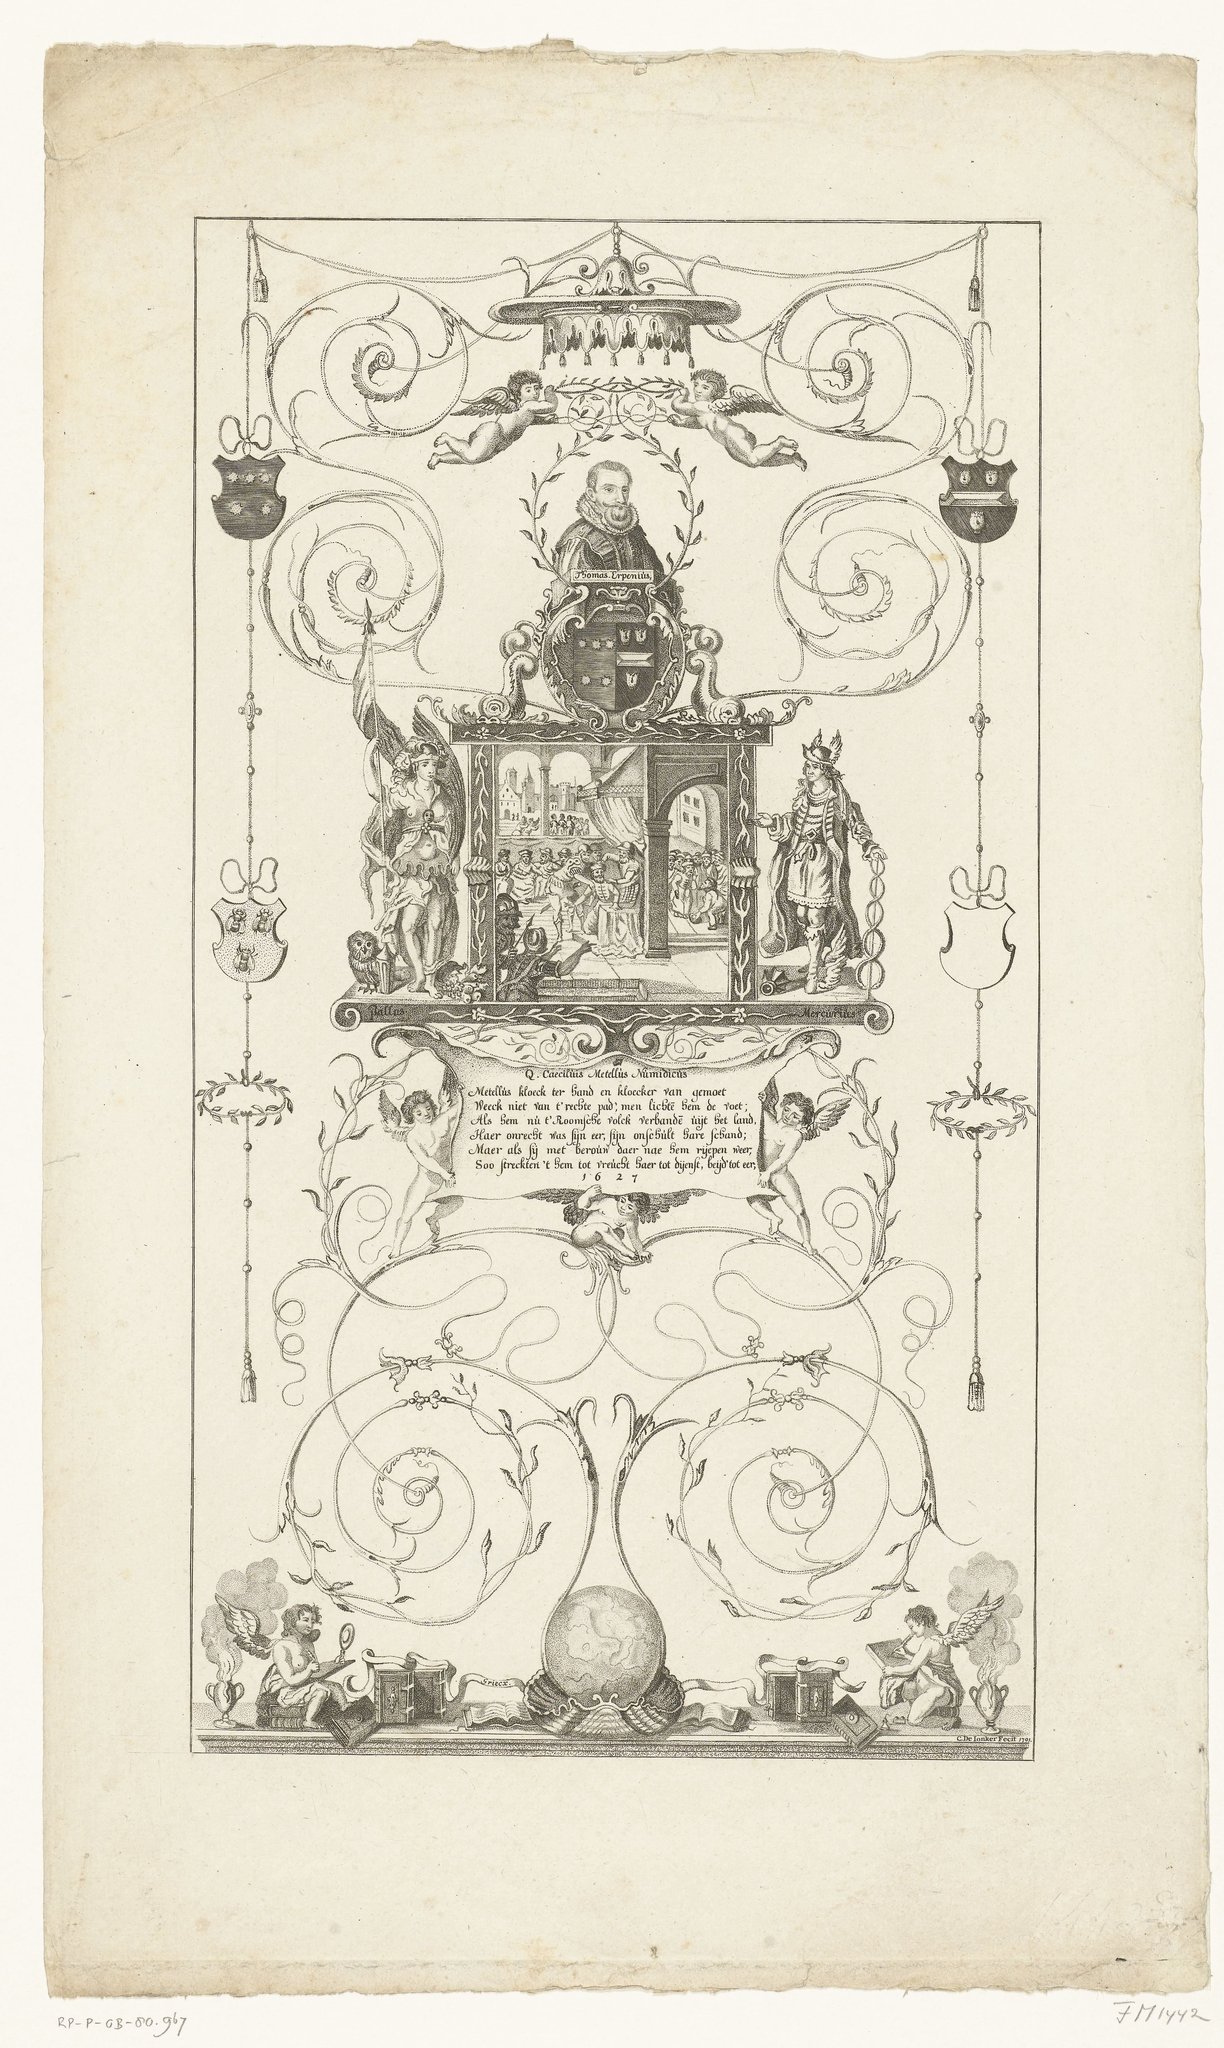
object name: historical object representation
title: Drie allegorische glasruiten in het huis van Abraham Daatselaar, ter herinnering aan de gevangenschap, vlucht en ballingschap van Hugo de Groot, 1619-1622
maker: cornelis de jonker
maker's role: draughtsman, print maker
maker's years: 1761-1830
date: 1791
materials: paper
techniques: etching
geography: netherlands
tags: delft, hugo de groot, leiden, art (+ making stained glass), window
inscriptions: date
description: Glasruit met scène uit het historie van Metellus, bekroond met een buste van Thomas Erpenius, 1627. Metellus keert terug na een lange ballingschap. Aan weerszijden Pallas en Mercurius, verder versierd met ranken, wapens en putti. Onder de centrale scène een vers van 6 regels. Onderdeel van een serie van drie allegorische glasruiten ter herinnering aan de gevangenschap, vlucht en ballingschap van Hugo de Groot, 1619-1622. In 1627 vervaardigd voor het huis van Abraham Daatselaar, de koopman te Gorcum die Hugo de Groot heeft helpen ontvluchten.